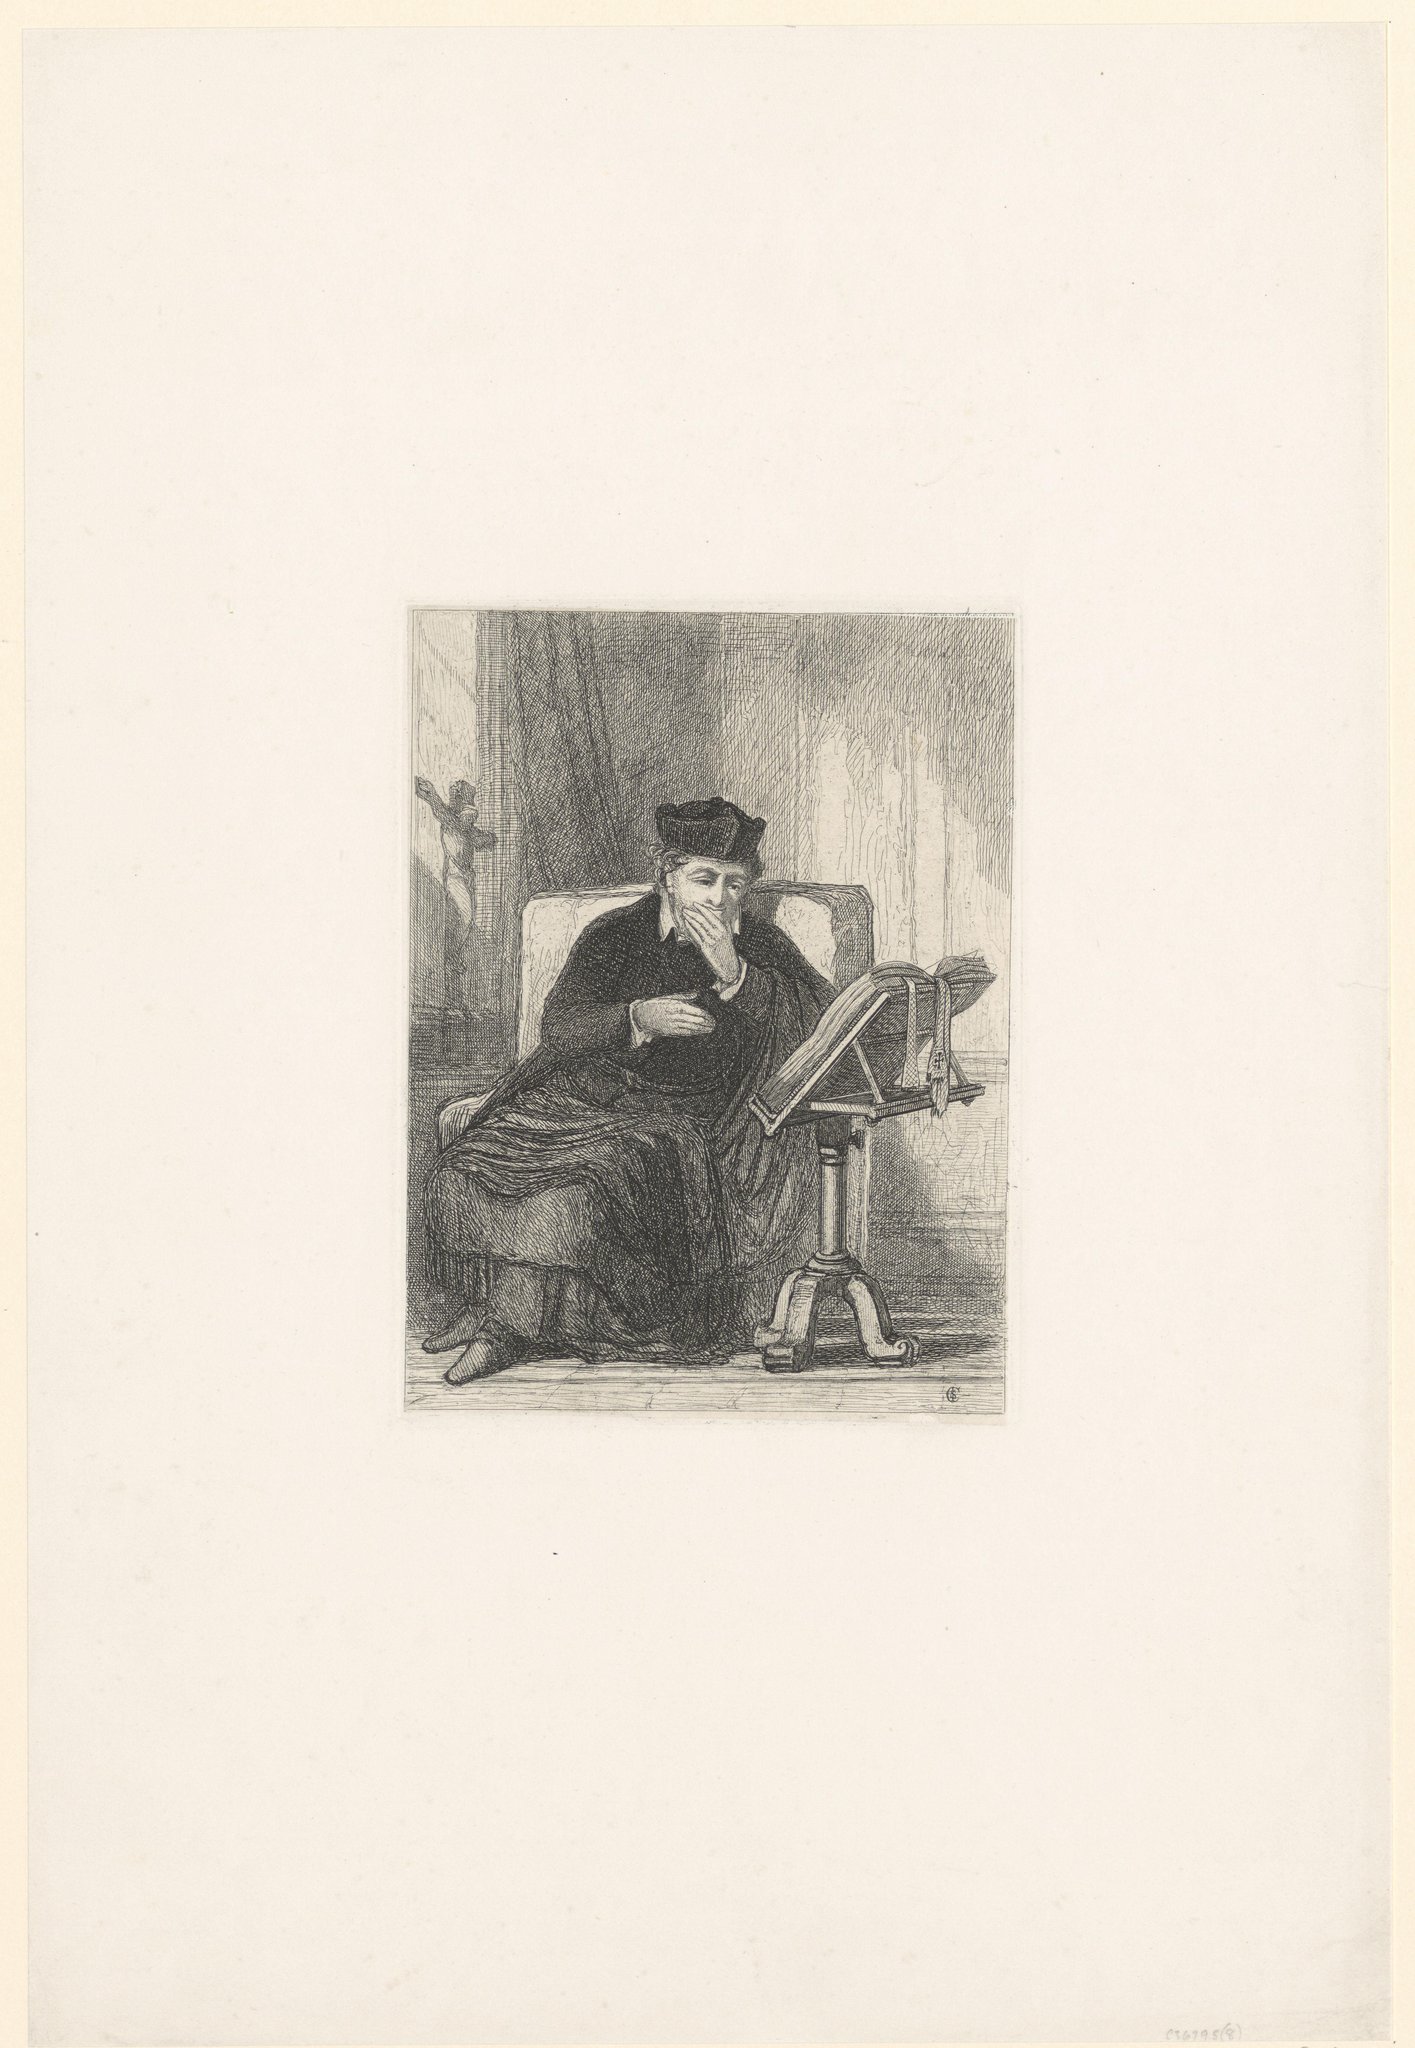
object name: print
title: Eight original etchings by the late John Sell Cotman, now first published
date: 1792-1842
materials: paper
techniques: etching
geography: norwich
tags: sitting figure, reading, cross as symbol of christ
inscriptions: collector's mark: Lugt 2760, collector's mark: Lugt 2228